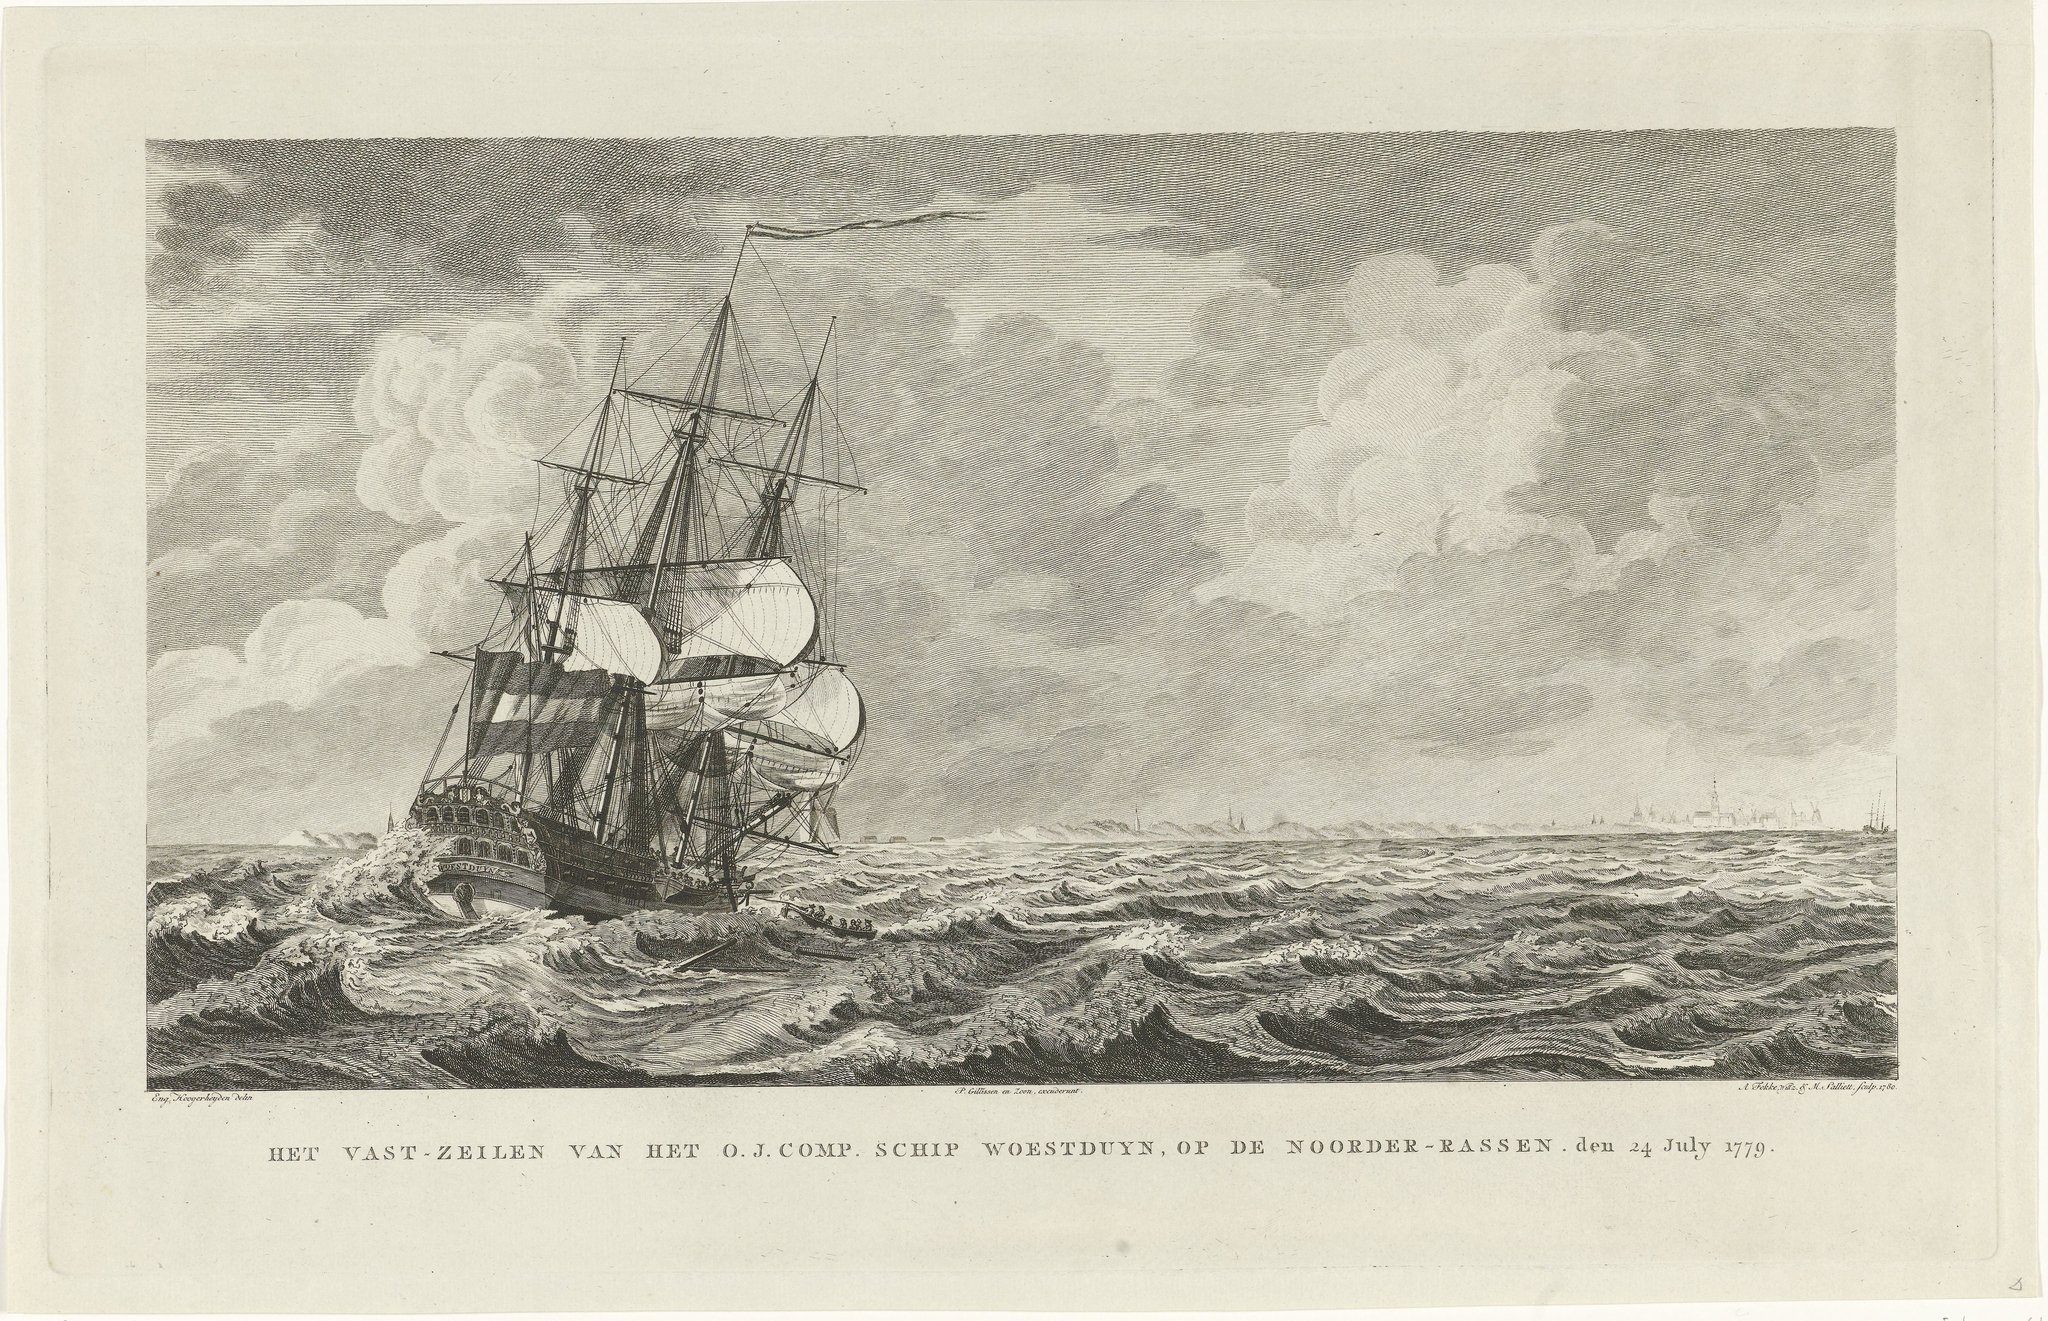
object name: print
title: Het vast-zeilen van het O.J. Comp. Schip Woestduyn, op de Noorder-Rassen. den 24 July 1779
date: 1780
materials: paper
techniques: engraving, etching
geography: middelburg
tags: shipwreck, exploration, expedition, voyage of discovery, flushing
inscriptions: collector's mark: Lugt 2228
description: Het VOC-schip 'Woestduin' van de Kamer Amsterdam is vlak voor terugkeer van zijn vijfde thuisreis uit Batavia op de Noorderassen bij Vlissingen vastgelopen. De bemanning wordt gered met sloepen onder leiding van de Vlissinger zeeloodsen, de gebroeders Frans en Jacob Naerebout.